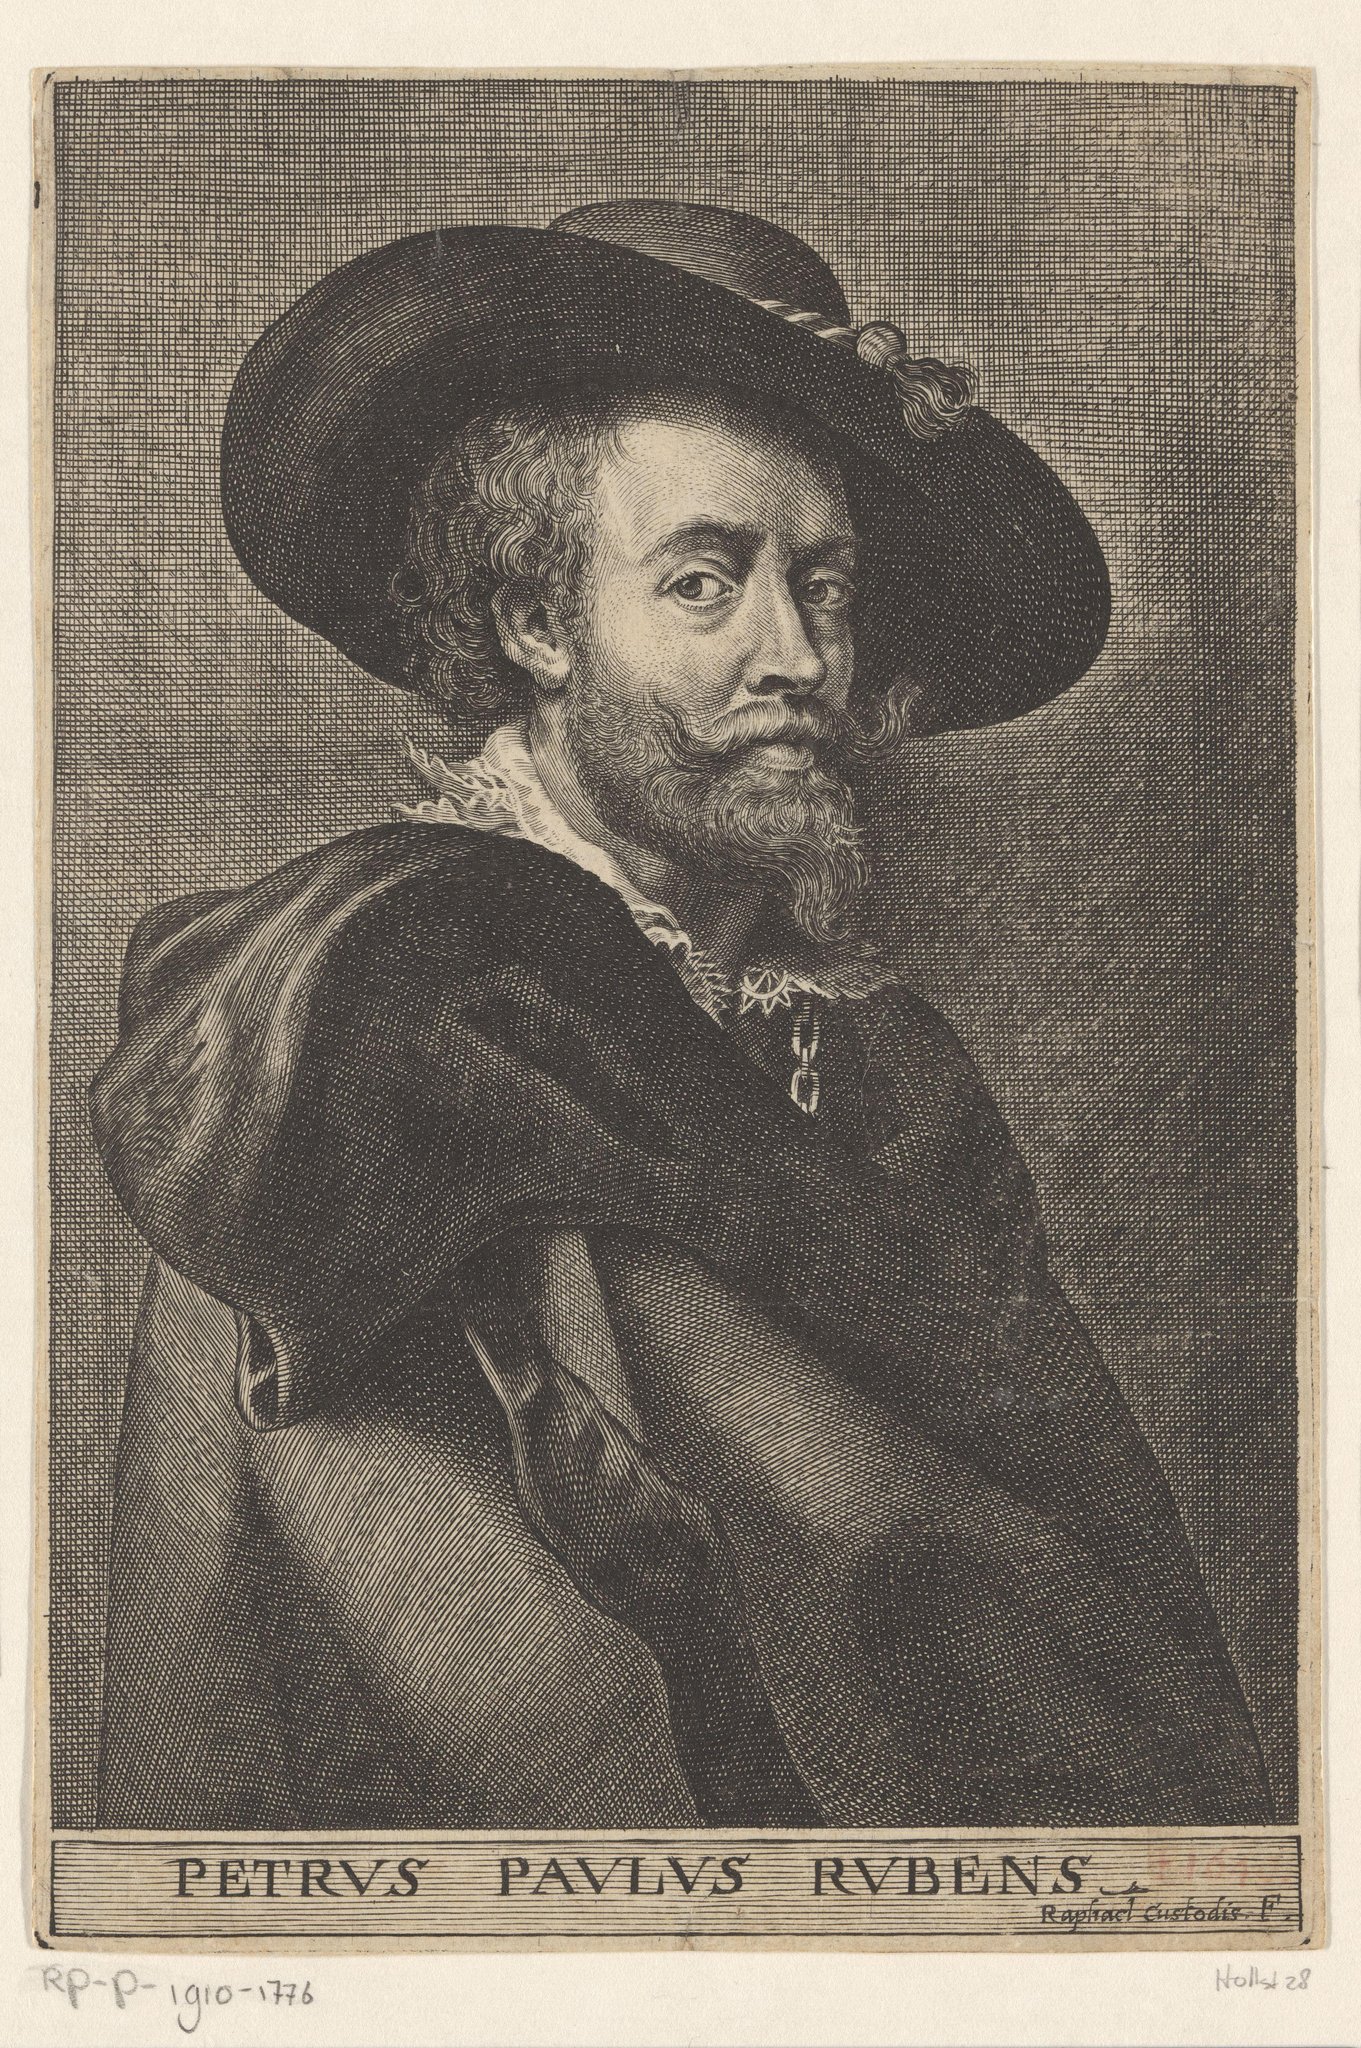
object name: print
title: Petrus Paulus Rubens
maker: raphael custos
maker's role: print maker, publisher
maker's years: 1590-1664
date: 1600-1640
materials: paper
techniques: engraving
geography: augsburg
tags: antwerp, painter, draughtsman, peter paul rubens, portrait, self-portrait of painter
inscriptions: collector's mark: Lugt 2228